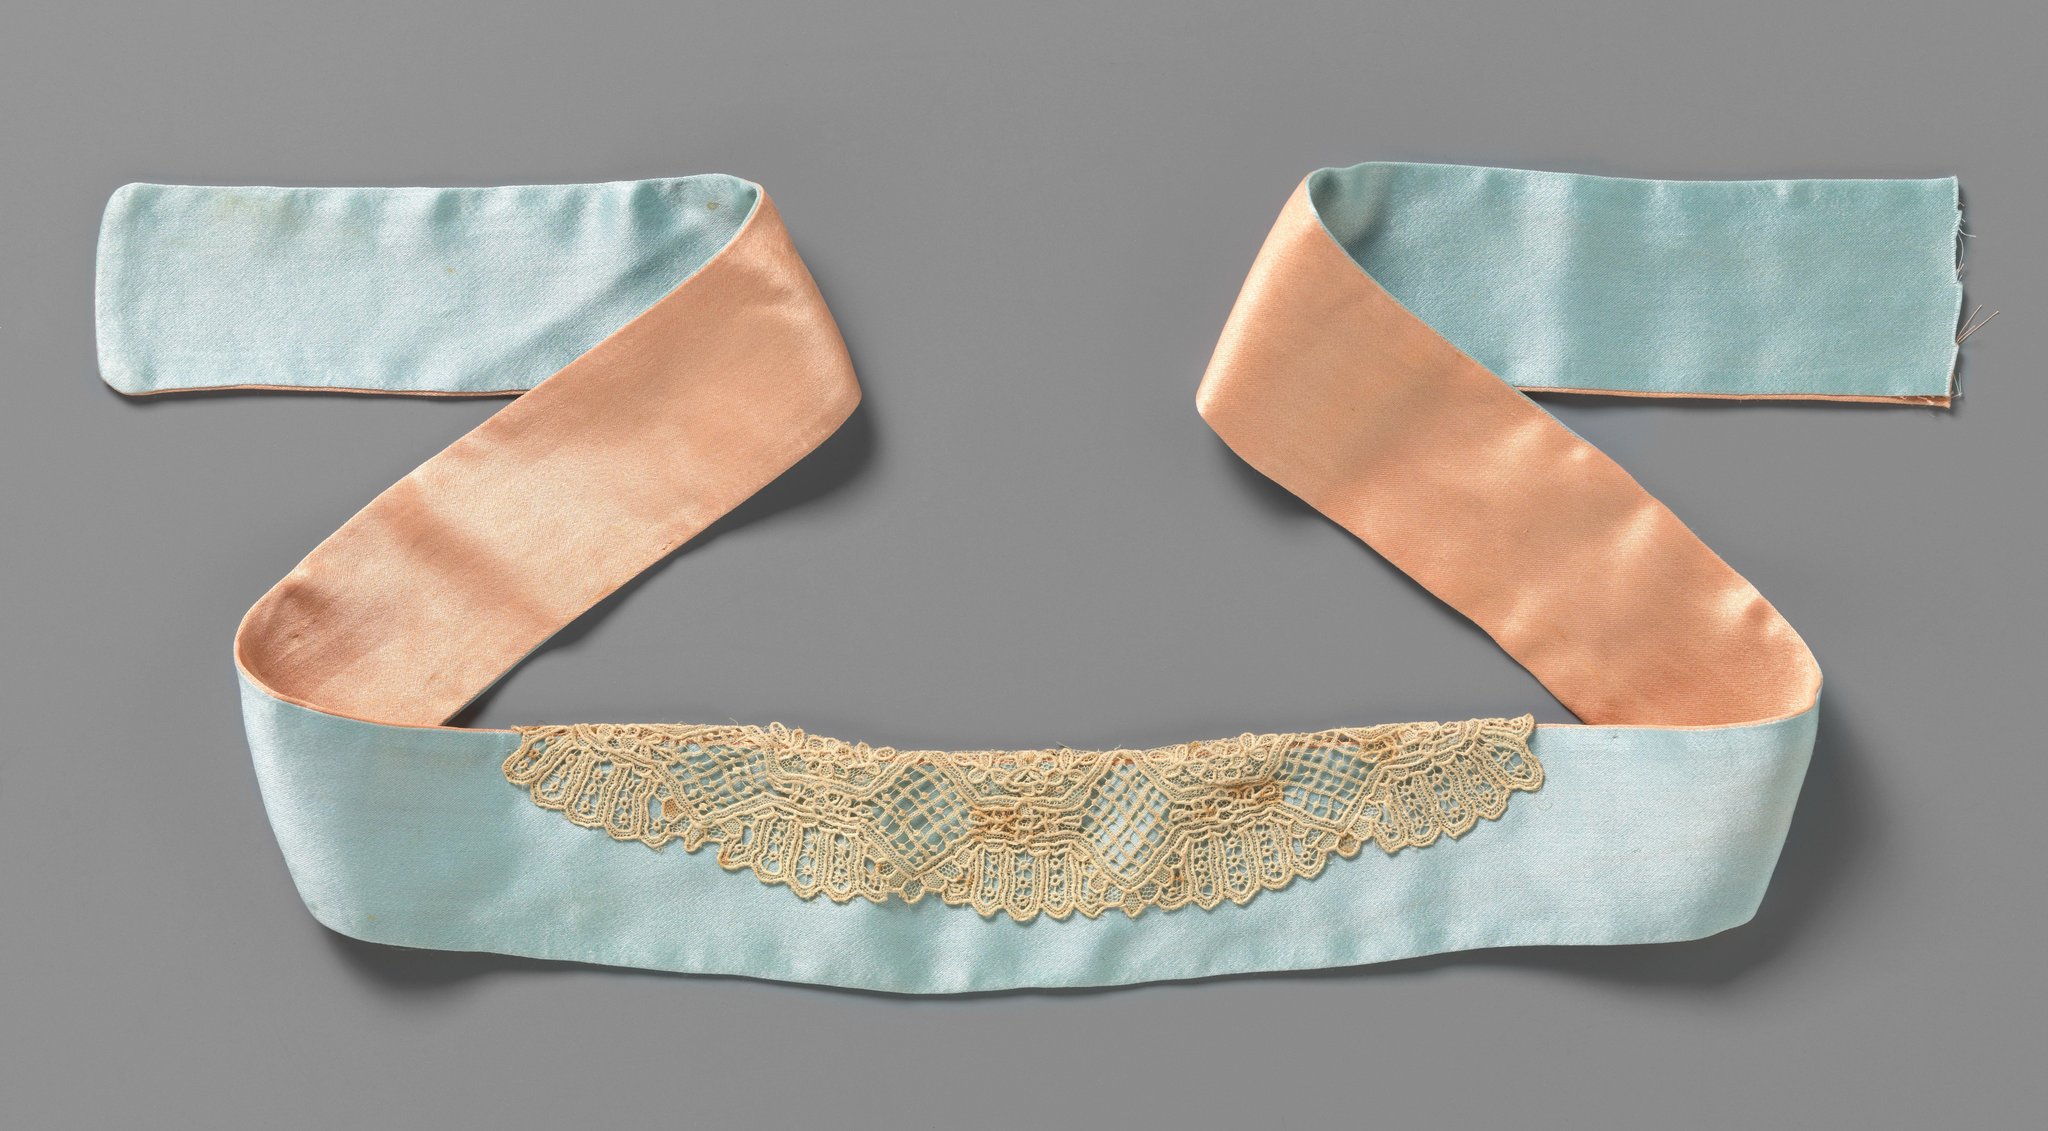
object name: womenswear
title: Manchet van naaldkant genaaid op het middenstuk van een blauw-roze satijnen band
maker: Anonymous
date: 1860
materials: linen, textile, silk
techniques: lace, weave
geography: brussels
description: Manchet van naturelkleurige naaldkant - Brusselse gaaskant - genaaid op het middenstuk van een satijnen band. De band is aan de ene kant roze en aan de andere kant blauw. Het kant is op het blauwe gedeelte genaaid, waarbij een smal randje over de rand is gebogen en is vastgezet aan het roze gedeelte. Aan de andere lange zijde van de band loopt het kant niet helemaal tot de rand. Het kantpatroon bestaat langs de boven- en onderzijde uit trapeziumvormige velden waartussen ruitvormige velden gevormd worden. In elk trapeziumvormig veld aan de ene kant ligt steeds één rozetbloem en in de tegenoverliggende velden staan halfovaalvormige lobben met cirkeltjes erin. De ruitvormige velden zijn gevuld met ruitvormig rasters.